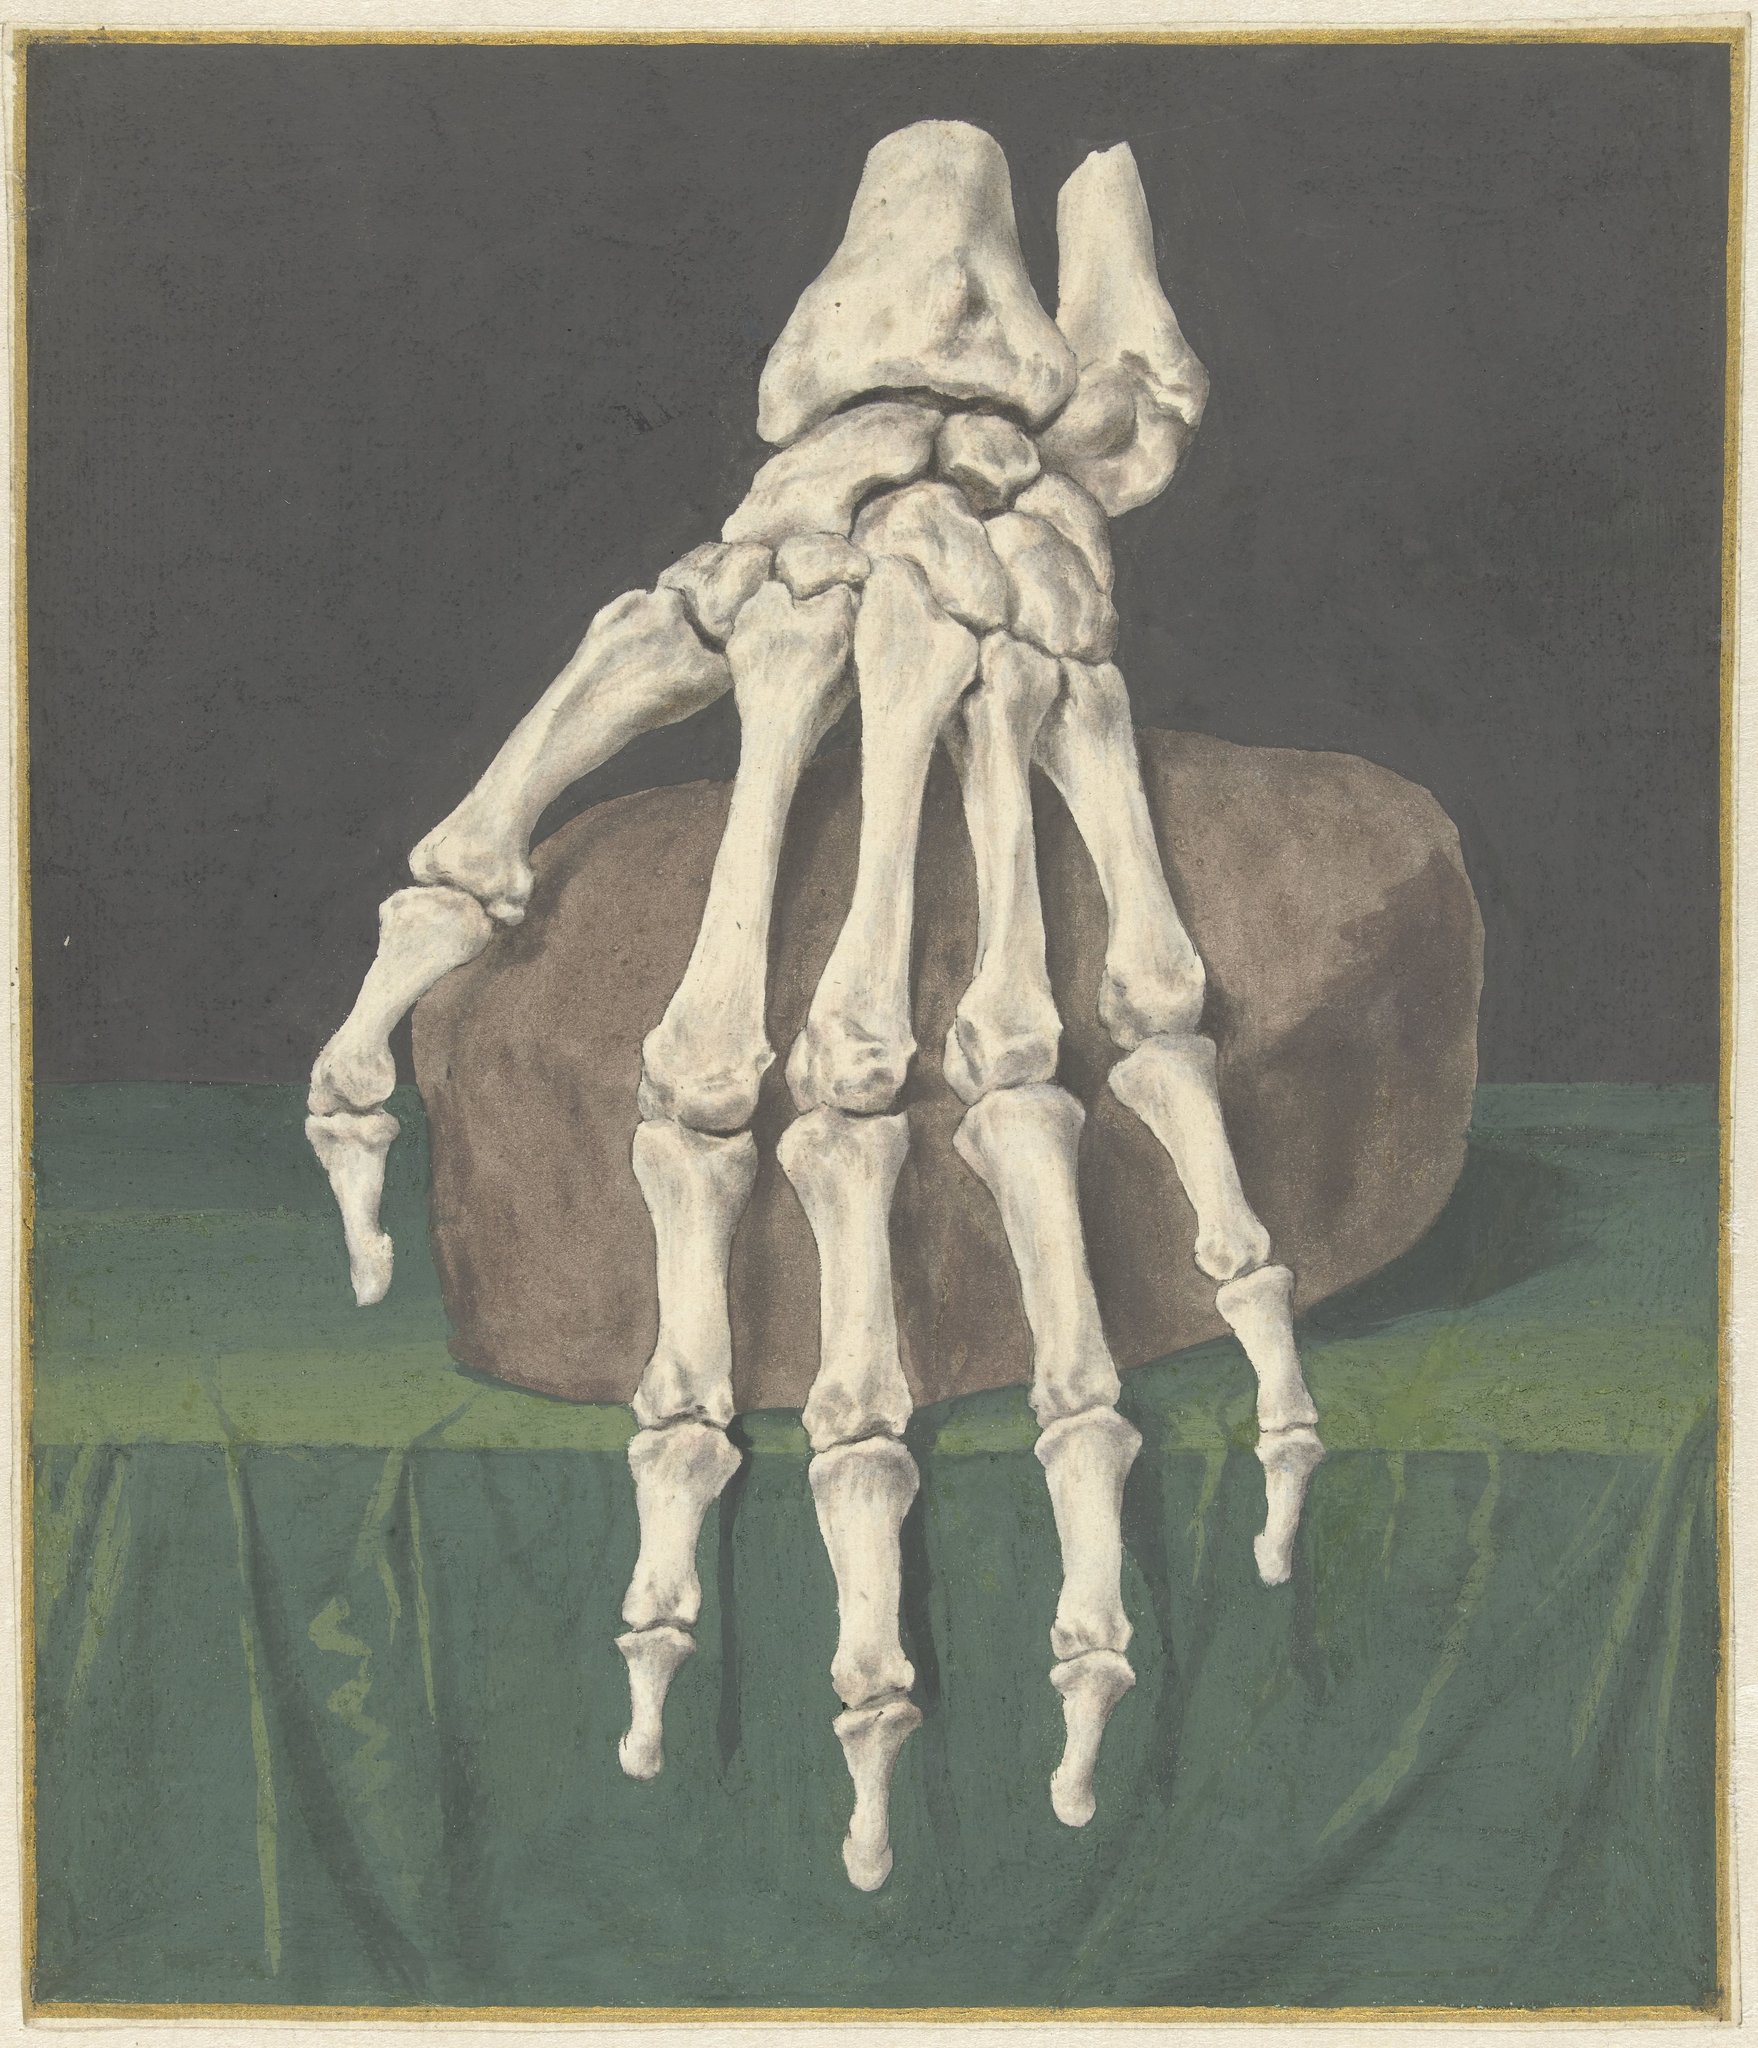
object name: drawing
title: Skelet van een hand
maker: jan l admiral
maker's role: draughtsman, print maker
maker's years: 1699-1773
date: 1709-1773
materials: gouache, paper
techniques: brush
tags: carpus and metacarpus, parts of the hand, phalanges of the fingers